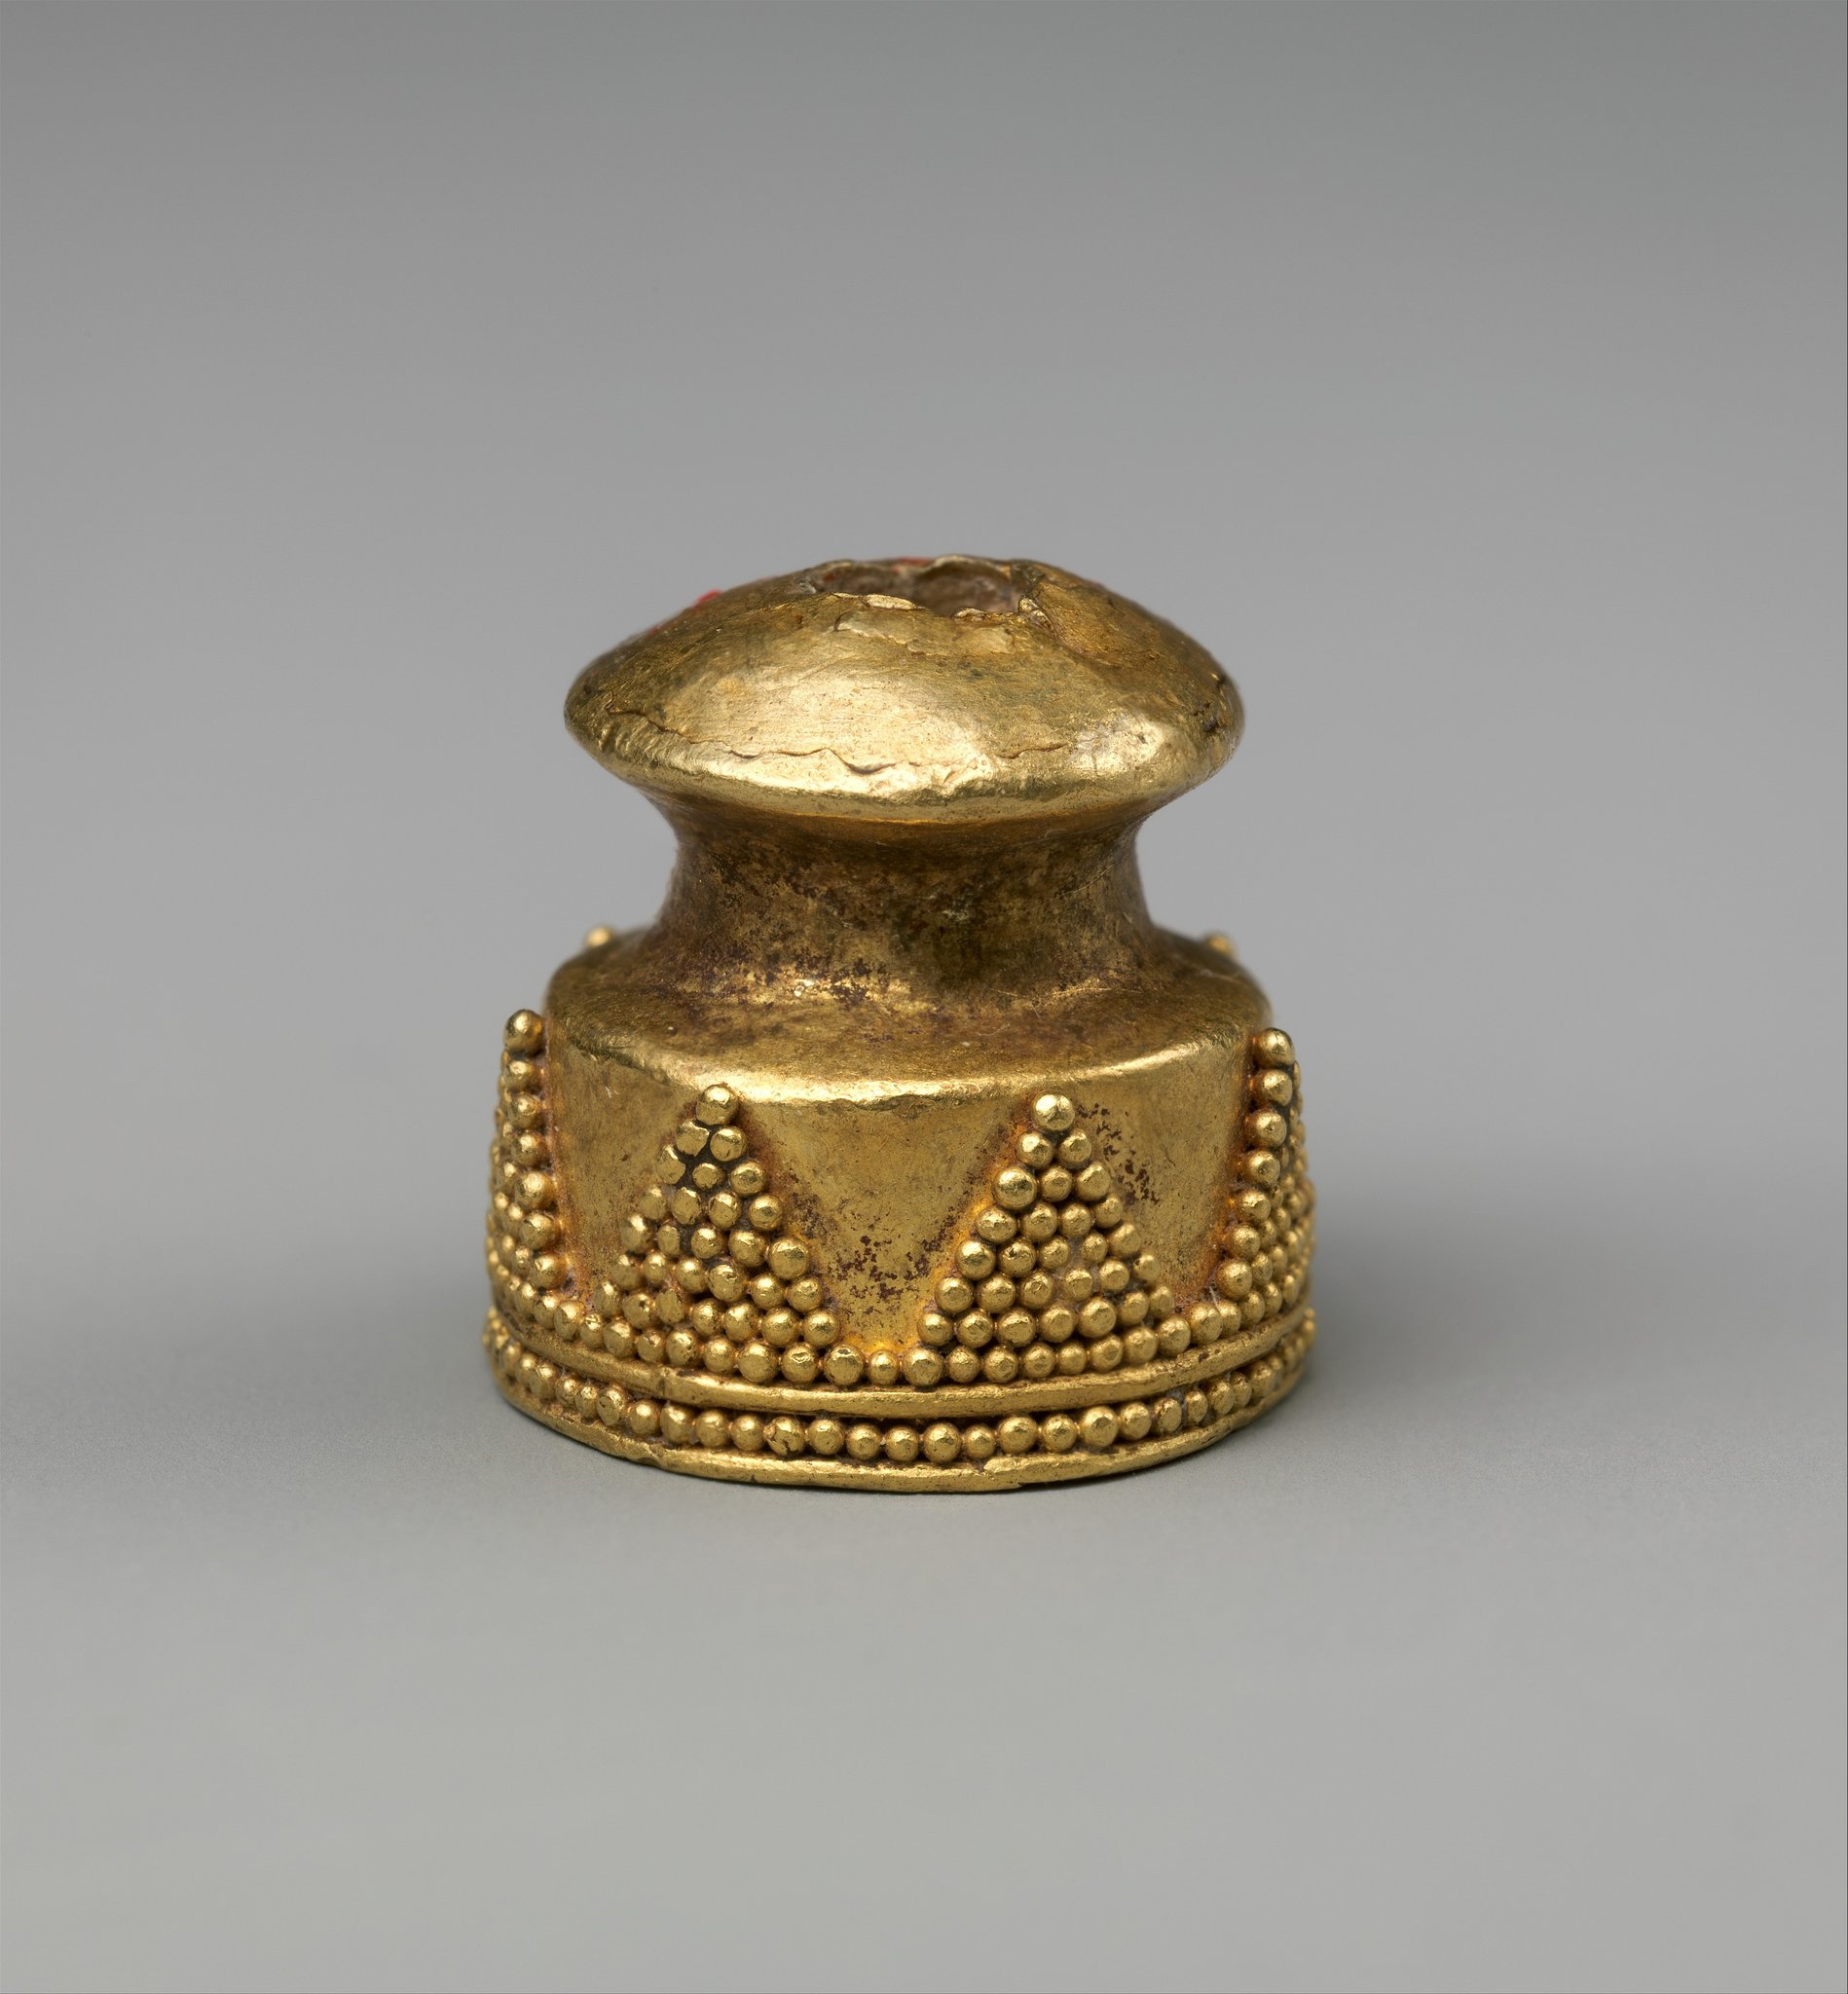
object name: cylinder seal cap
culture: babylonian or kassite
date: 1700-1501 BCE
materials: gold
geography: mesopotamia